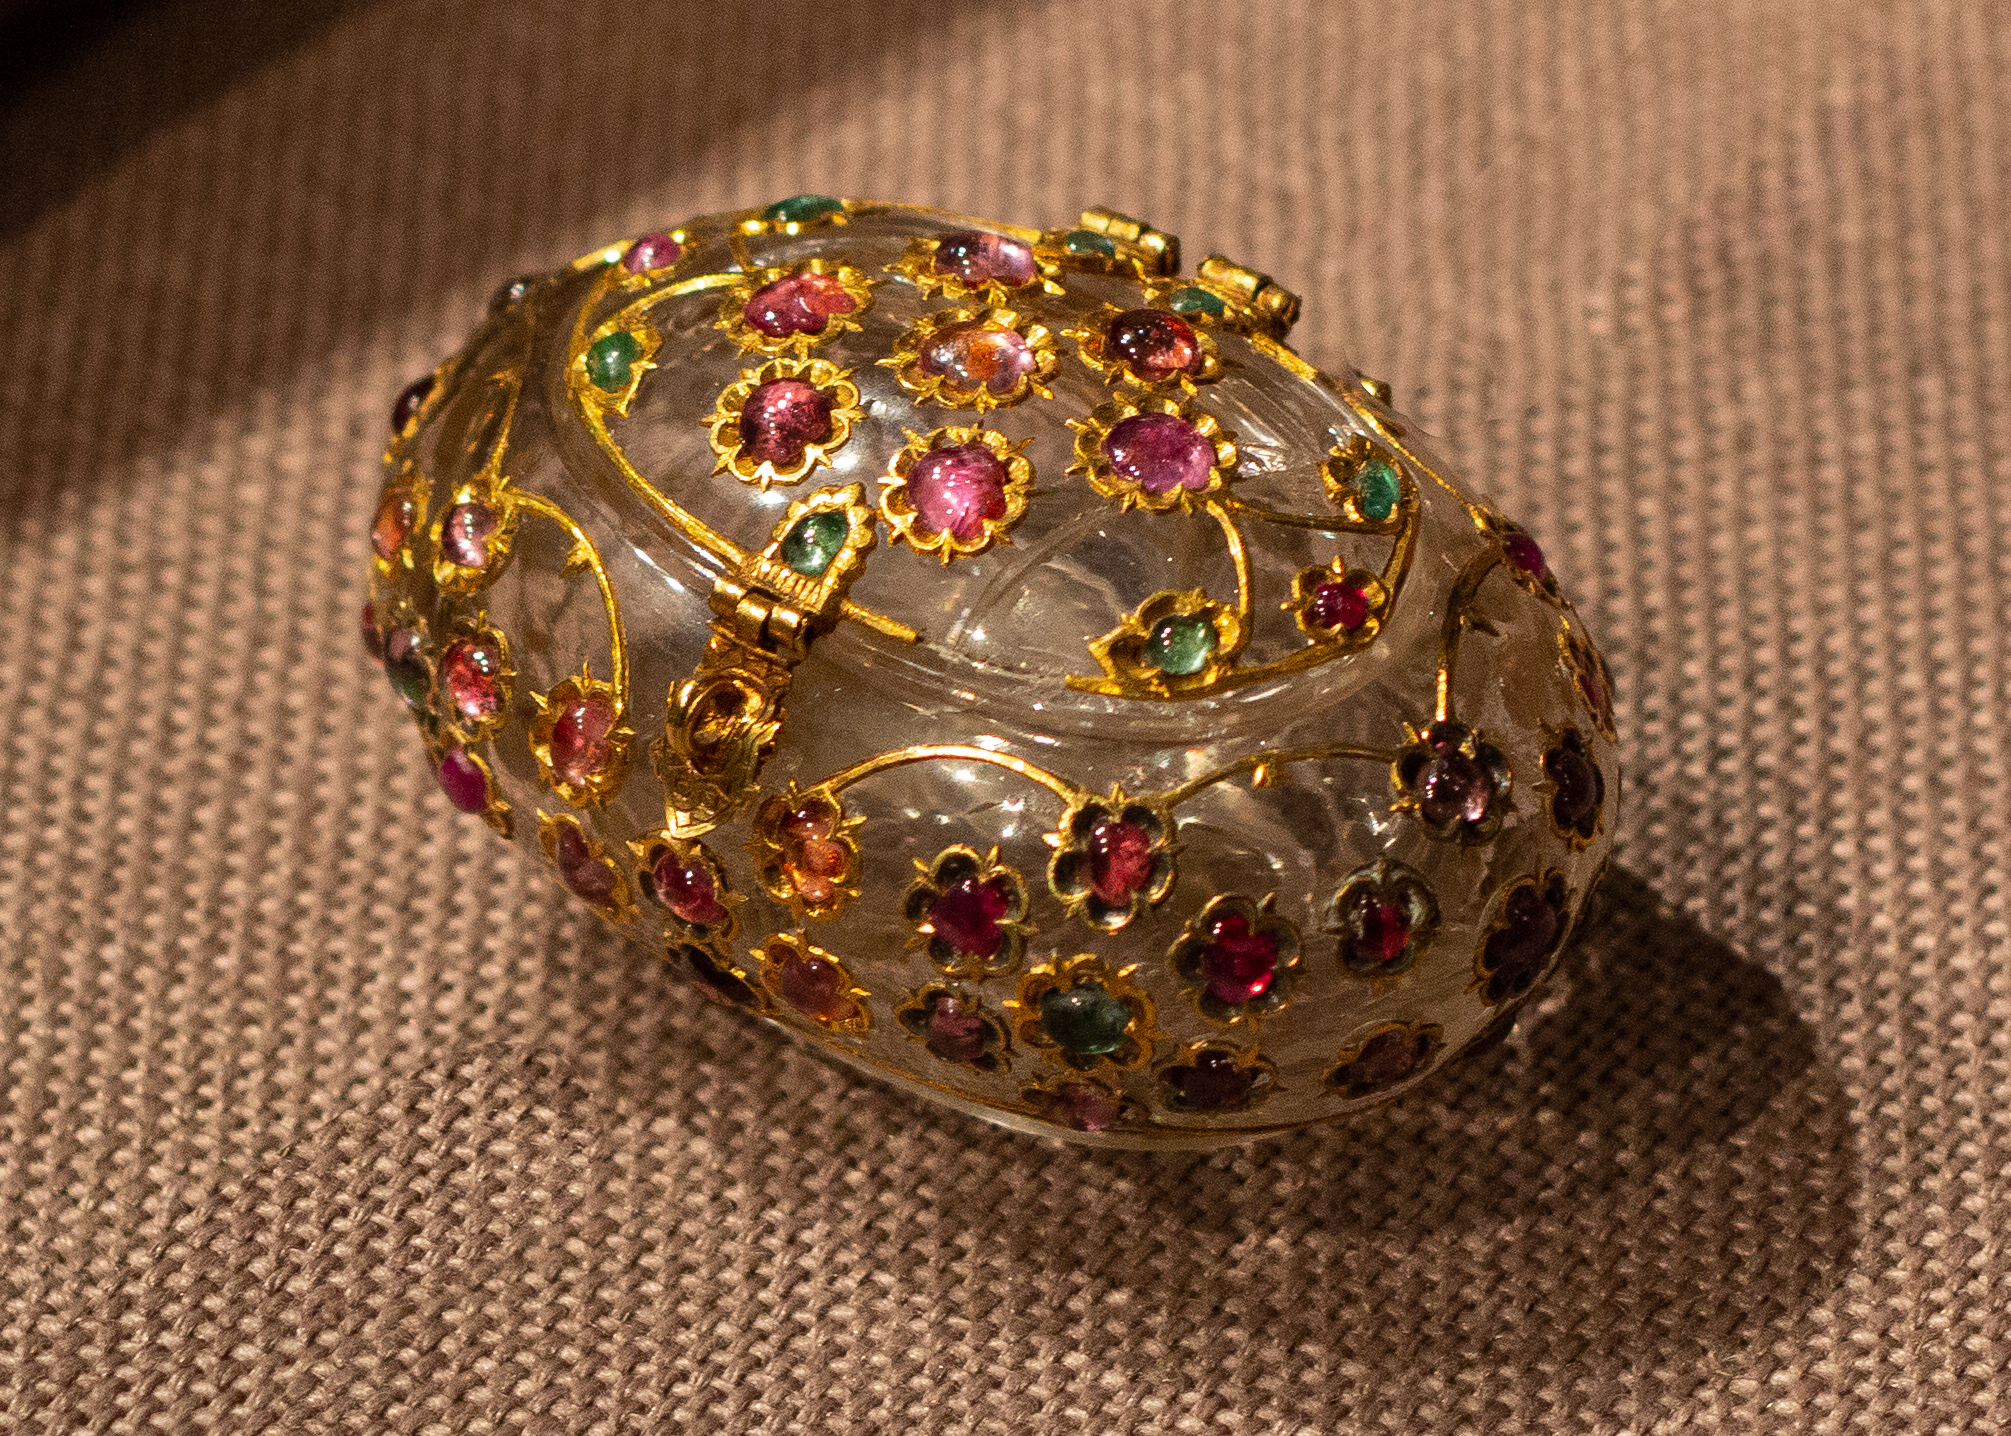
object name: box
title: Rock Crystal Box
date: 1701-1800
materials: gold, quartz, gemstone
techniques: inlay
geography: india